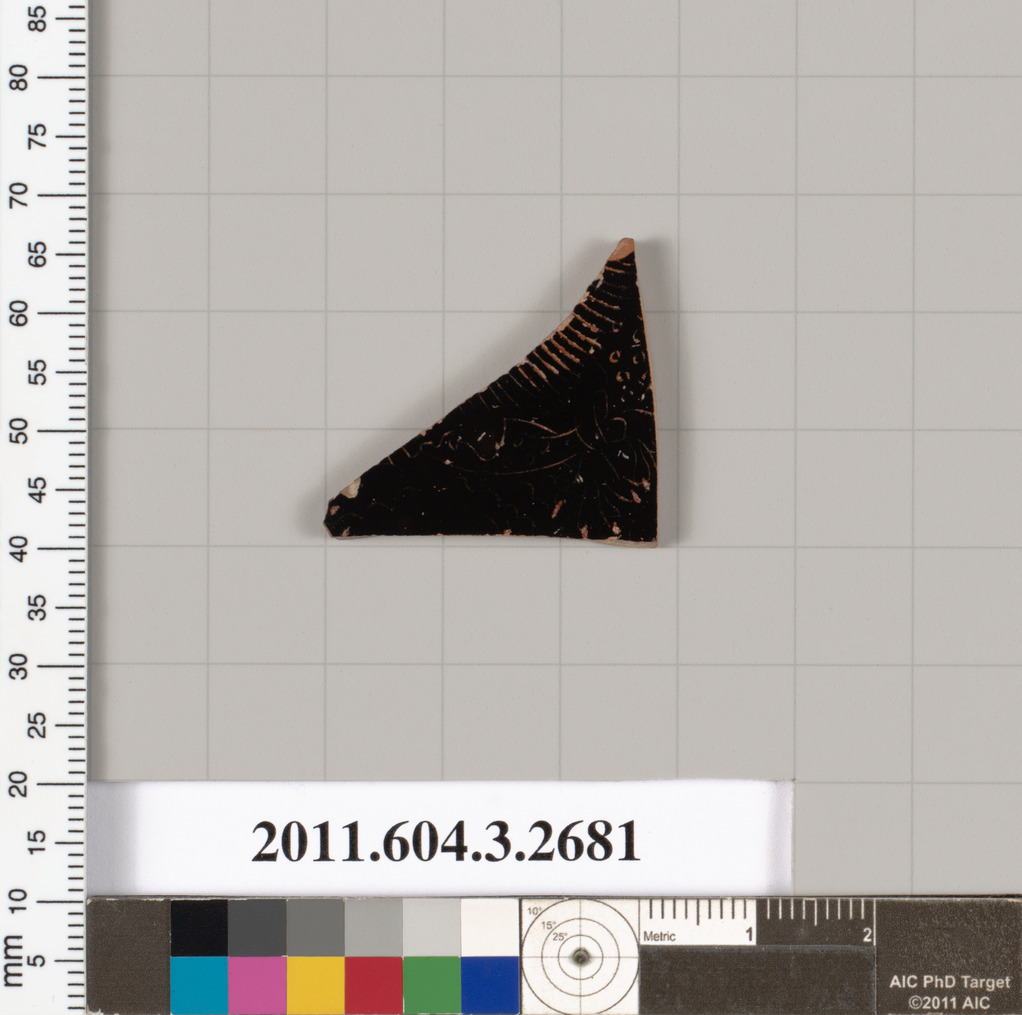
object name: oinochoe or olpe fragment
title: Terracotta fragment of an oinochoe (jug) or olpe (jug)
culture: greek, attic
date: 534-468 BCE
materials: terracotta